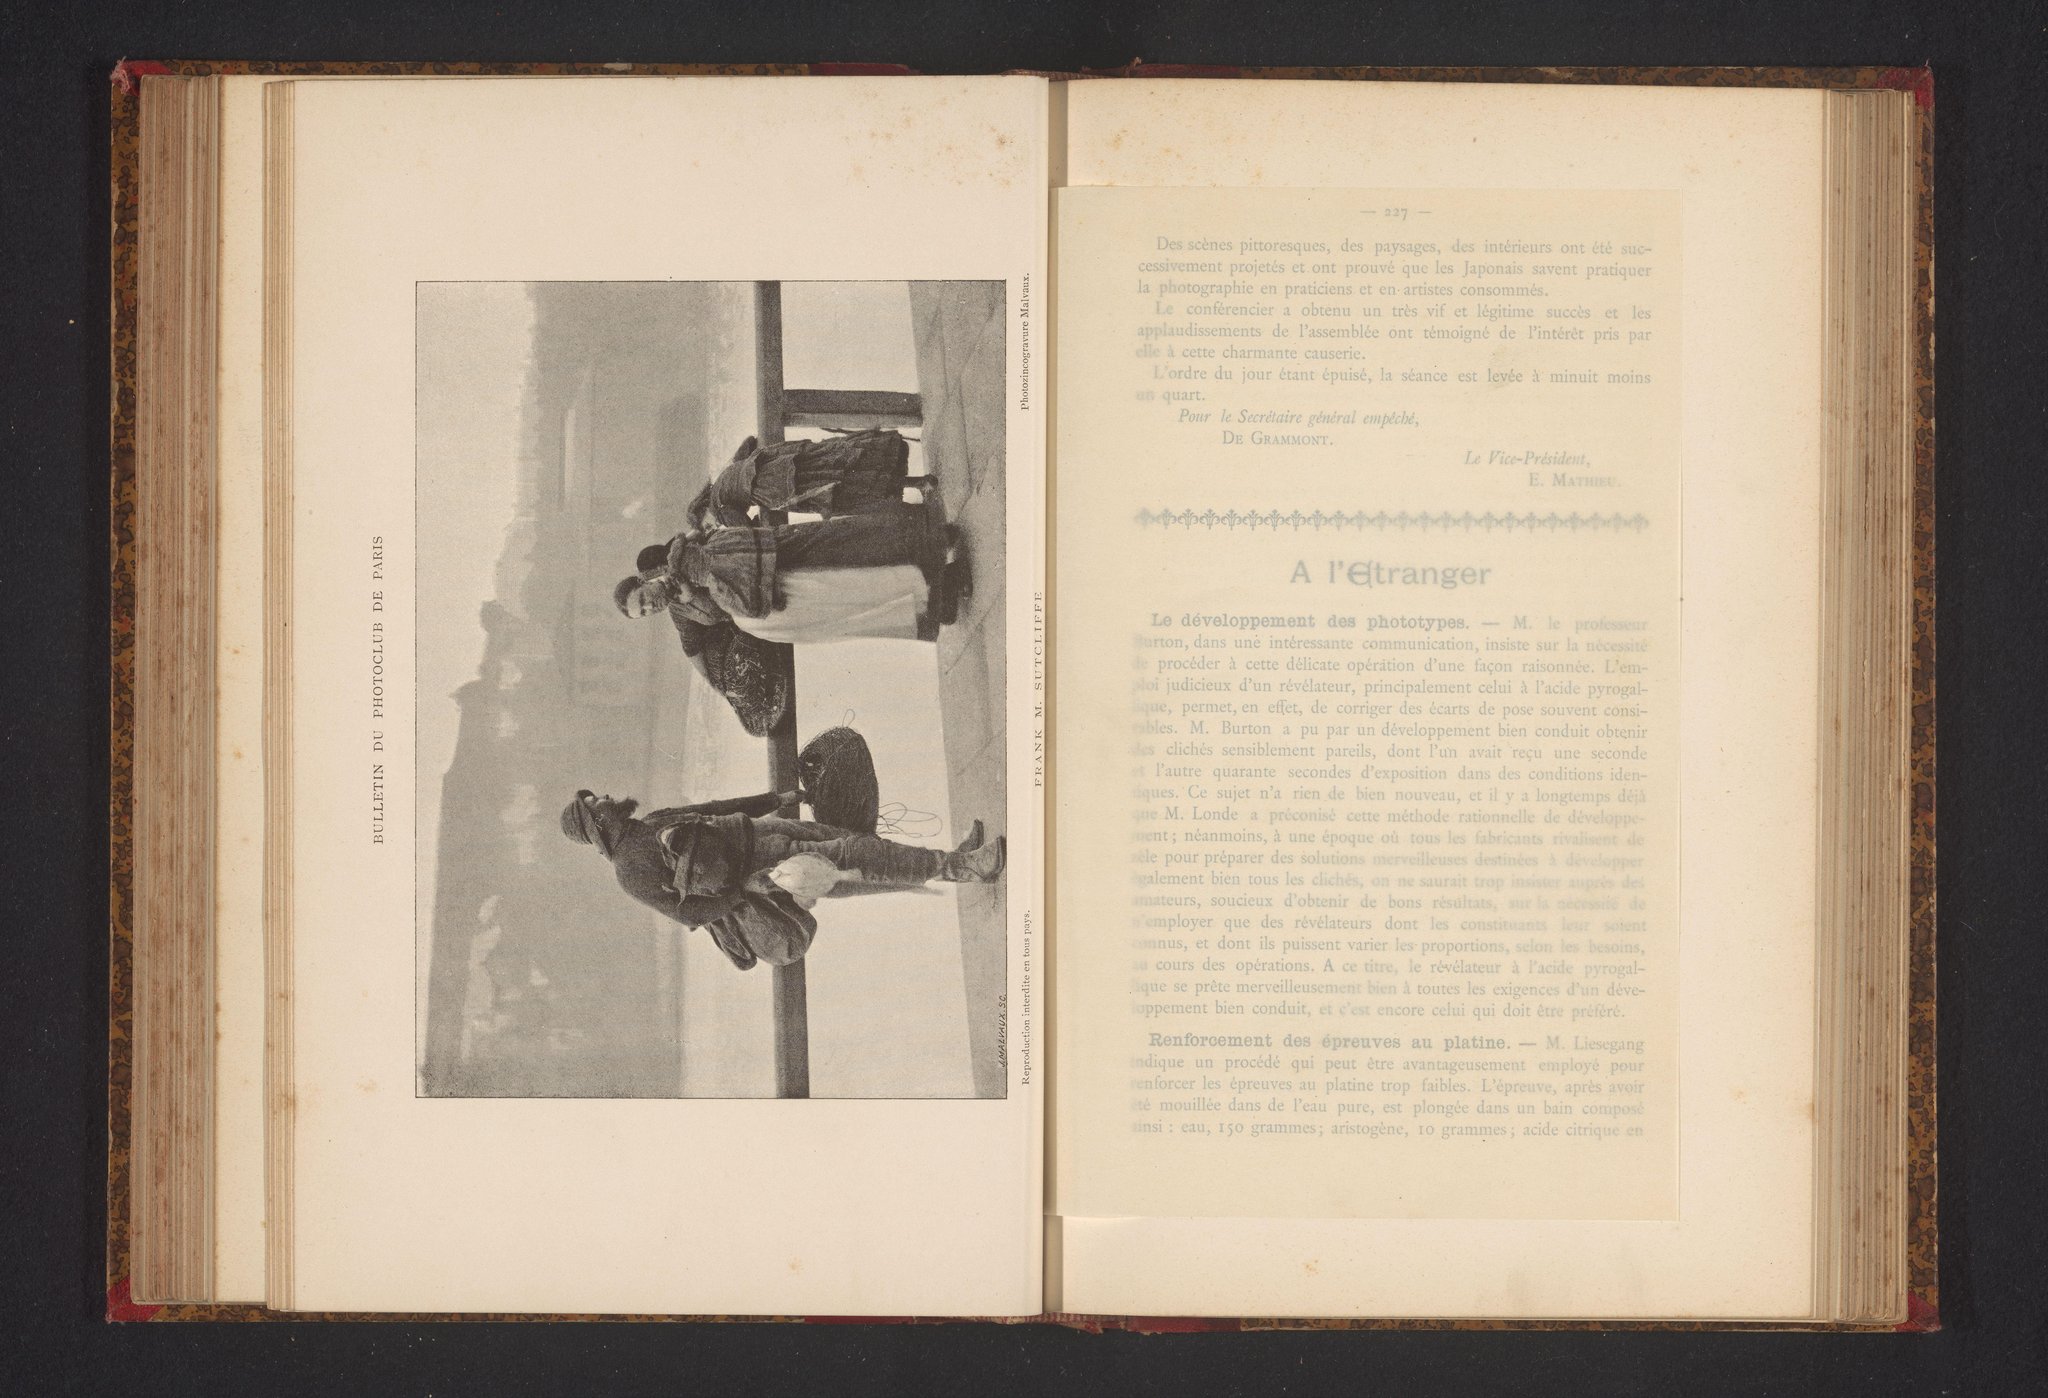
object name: page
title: Man en vrouw met twee kinderen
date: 1888-1893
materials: paper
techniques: autotype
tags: adult woman, adult man, toddler (male), girl (child between toddler and youth)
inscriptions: inscription: ‘Reproduction interdite en tous pays.’, inscription: ‘Bulletin du Photoclub de Paris’